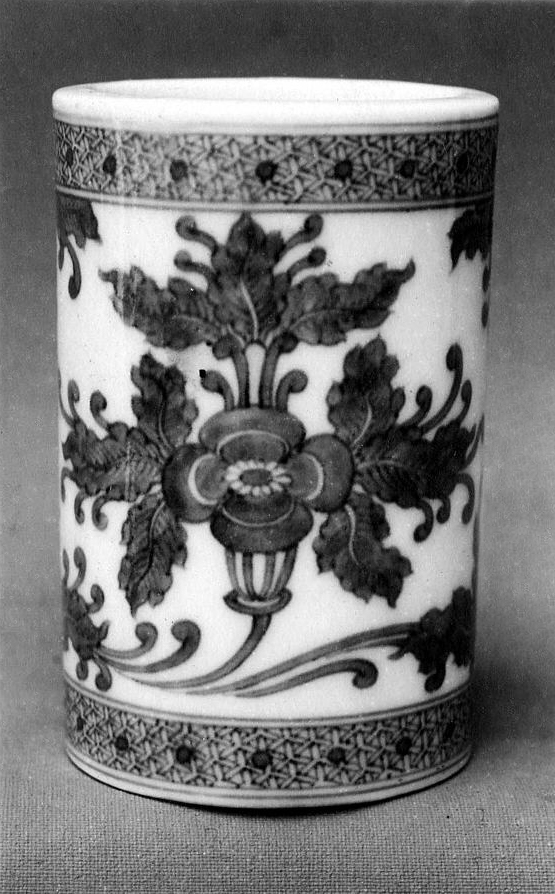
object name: brush holder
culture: japanese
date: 1820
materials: glaze, porcelain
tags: flowers